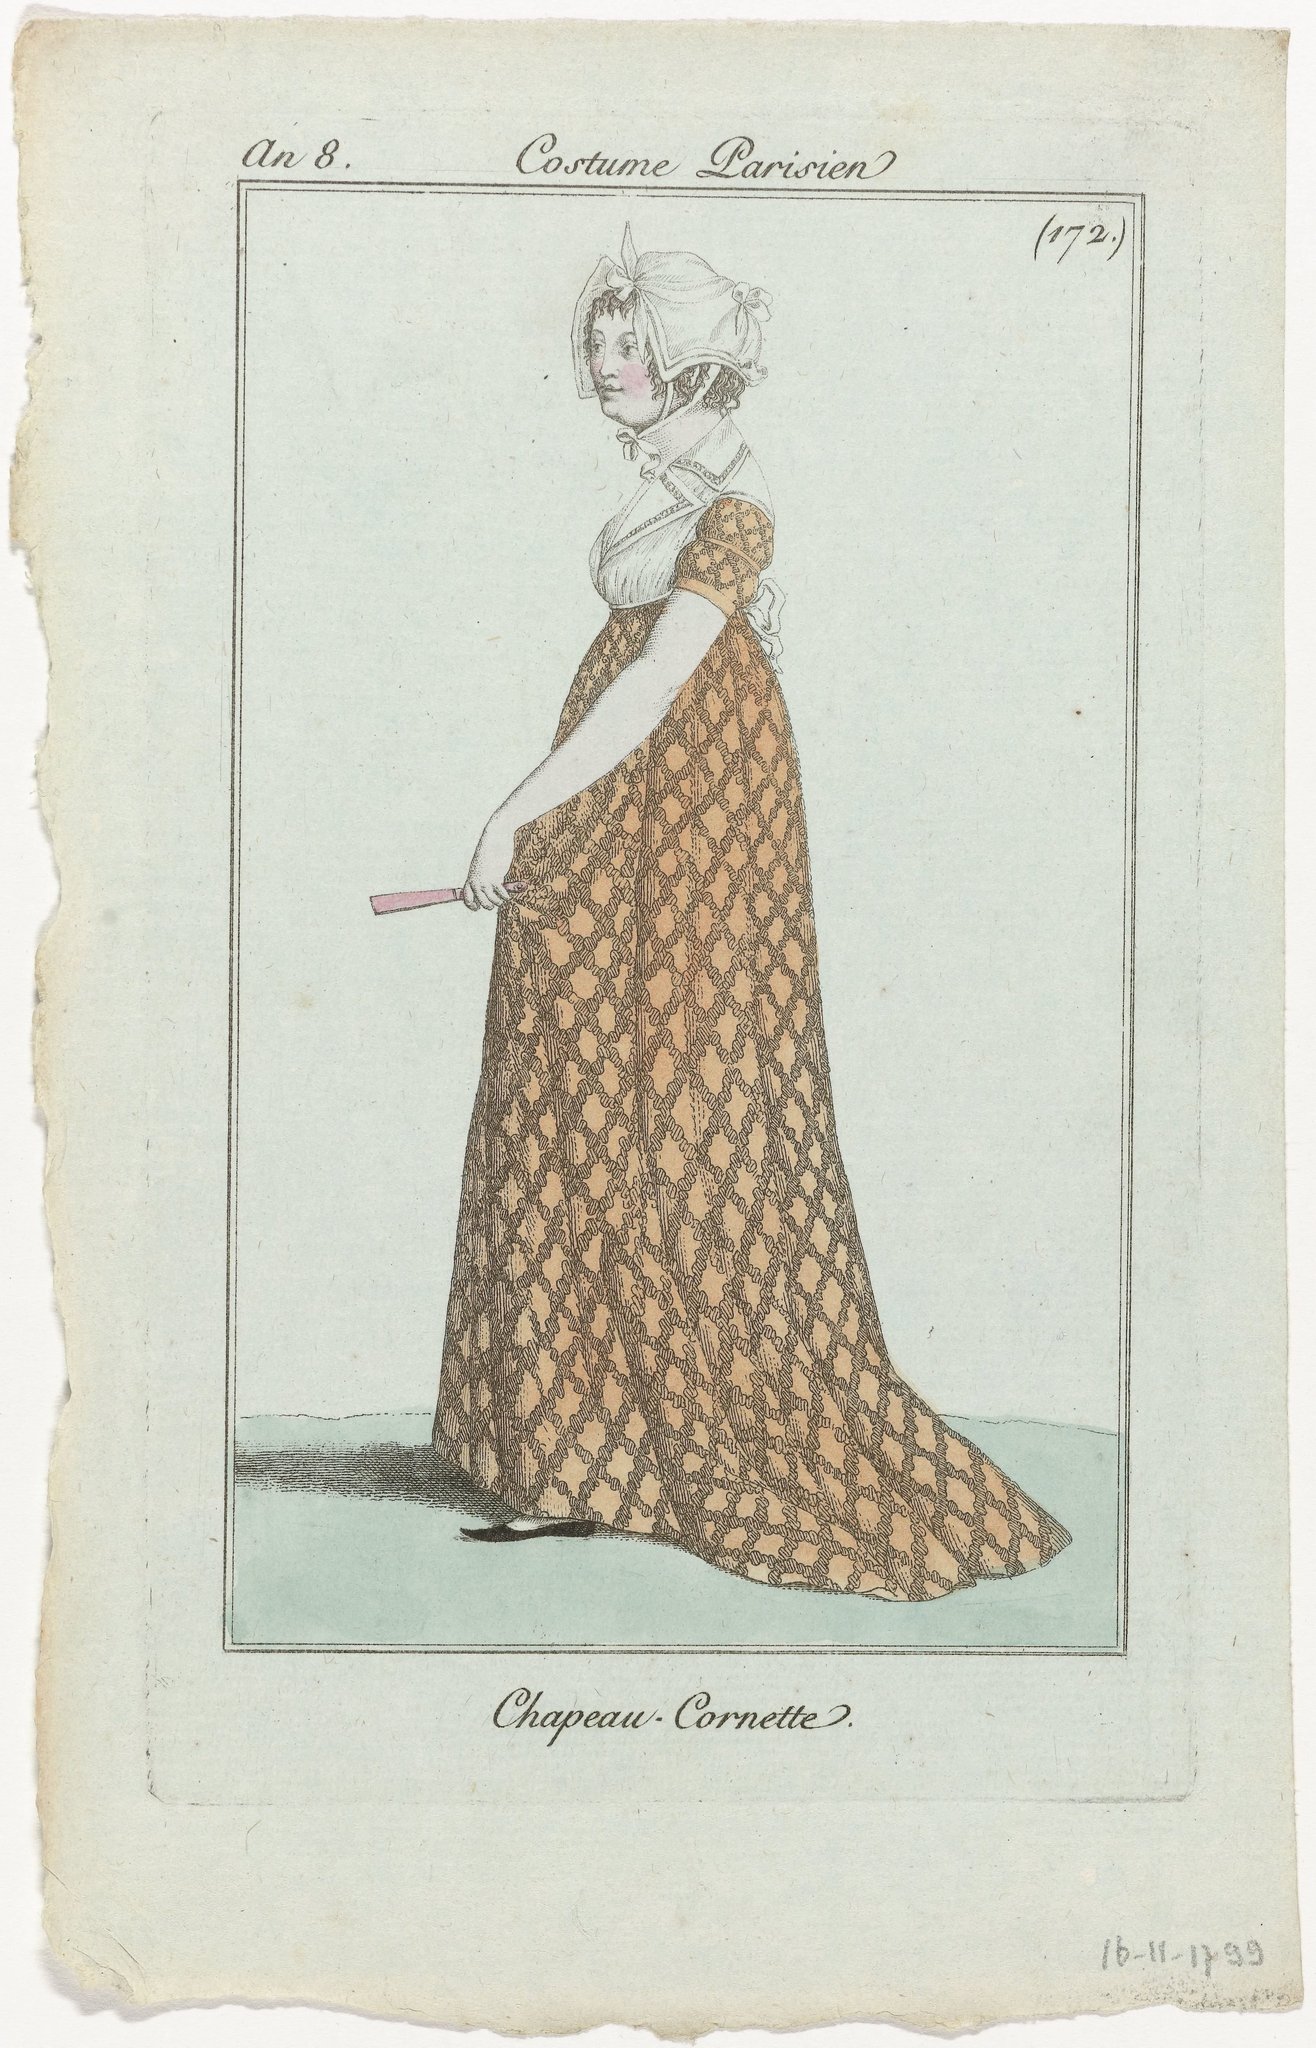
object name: fashion print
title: Journal des Dames et des Modes, Costume Parisien, 16 novembre 1799, An 8, (172.) : Chapeau-Cornette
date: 1799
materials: paper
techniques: engraving, hand coloring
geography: paris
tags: head-gear (cornette) (+ women's clothes), fashion plates, head-gear: hat (+ women's clothes), shoes, sandals (+ women's clothes), dress, gown (+ women's clothes), fan (+ women's clothes)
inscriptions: caption: ‘Chapeau-Cornette’, title: ‘Costume Parisien’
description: Staande vrouw met op het hoofd een 'Chapeau- Cornette'. Zij draagt een 'canezou' op een geruite japon met korte mouwen en sleep. Met de linkerhand houdt ze haar japon op. Waaier. platte schoen met puntige neus. De prent maakt deel uit van het modetijdschrift Journal des Dames et des Modes, uitgegeven door Pierre de la Mésangère, Parijs, 1797-1839.